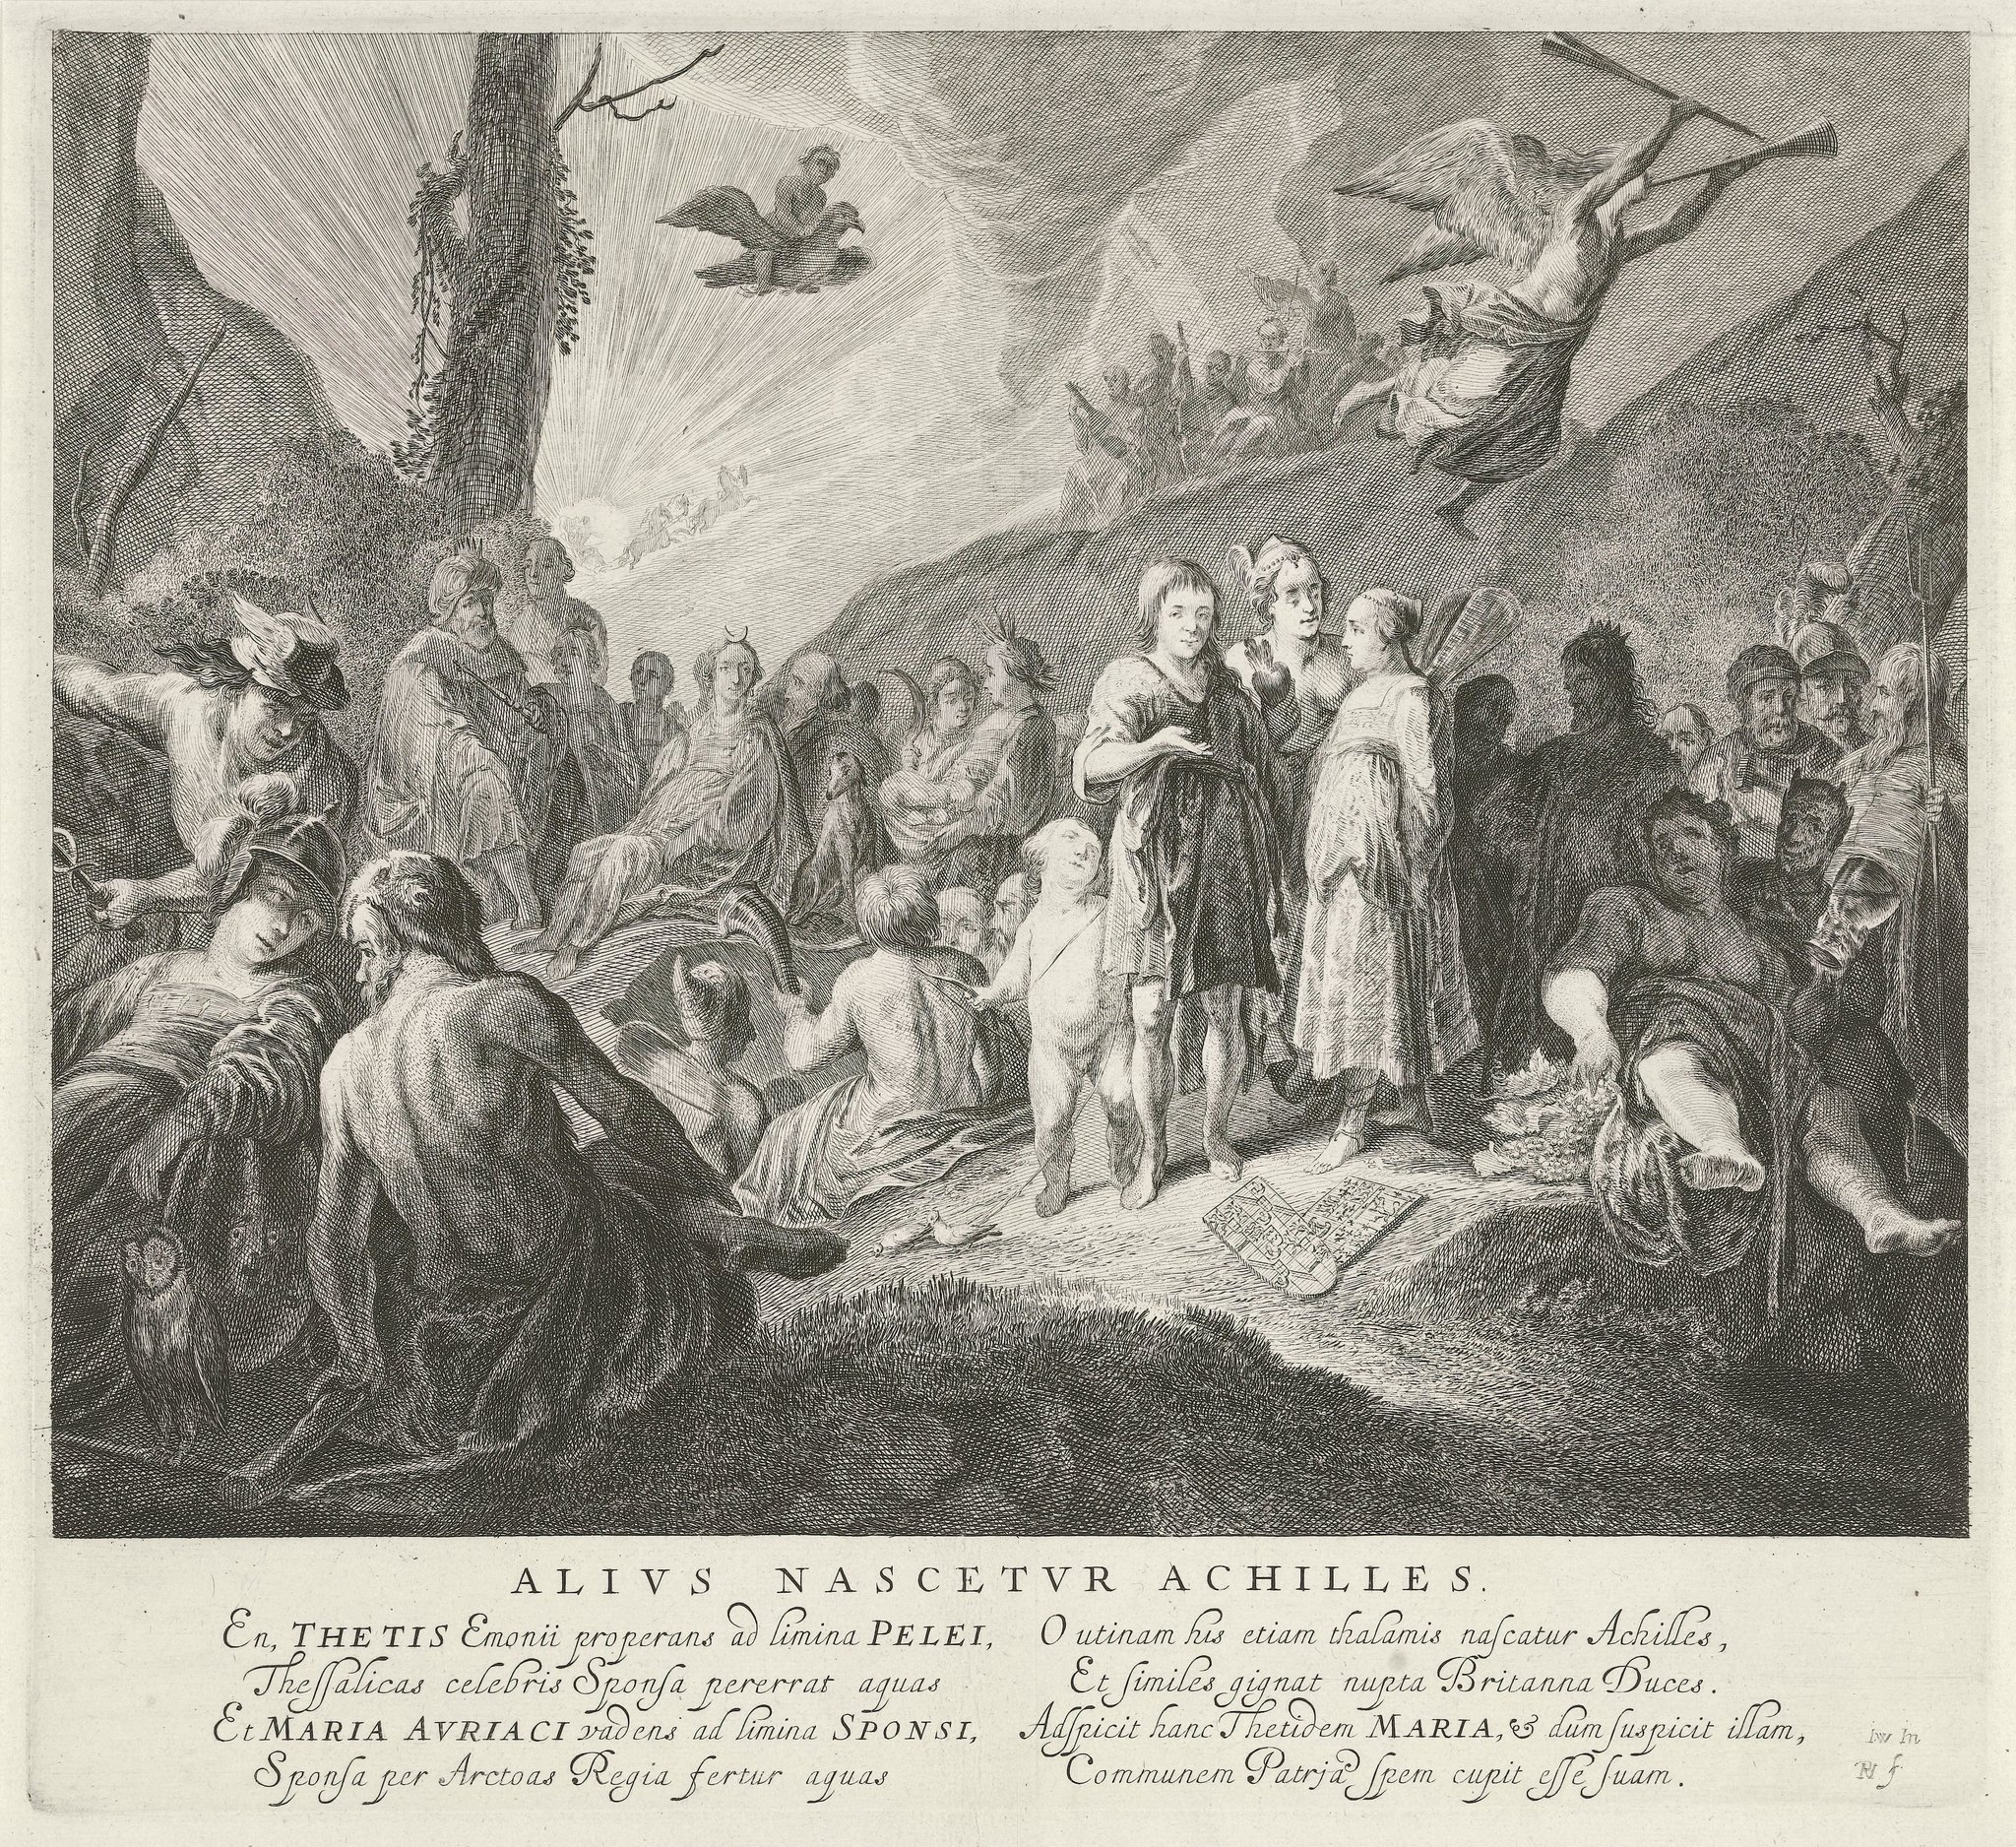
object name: print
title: Tableau vivant met het huwelijk van Peleus en Thetis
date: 1642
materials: paper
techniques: engraving, etching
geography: amsterdam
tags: 'tableau vivant', marriage of peleus and thetis, triumphal entry and public reception, pageant, 'entrée solennelle', 'joyeuse entrée'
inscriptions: collector's mark: Lugt 2228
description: Allegorisch tableau vivant met de godenmaaltijd en de bruiloft van Peleus en Thetis als parallel voor het huwelijk tussen Willem II en Maria Stuart in 1641. Het tableau vivant werd uitgevoerd in de theaterpoort, opgericht op de Dam bij het Damrak. Onderaan in de marge twee vierregelige teksten in het Latijn. Prent maakt deel uit van een serie over de vertoningen tijdens het bezoek van de Engelse koningin Henrietta Maria aan Amsterdam van 20 tot en met 22 mei 1642.